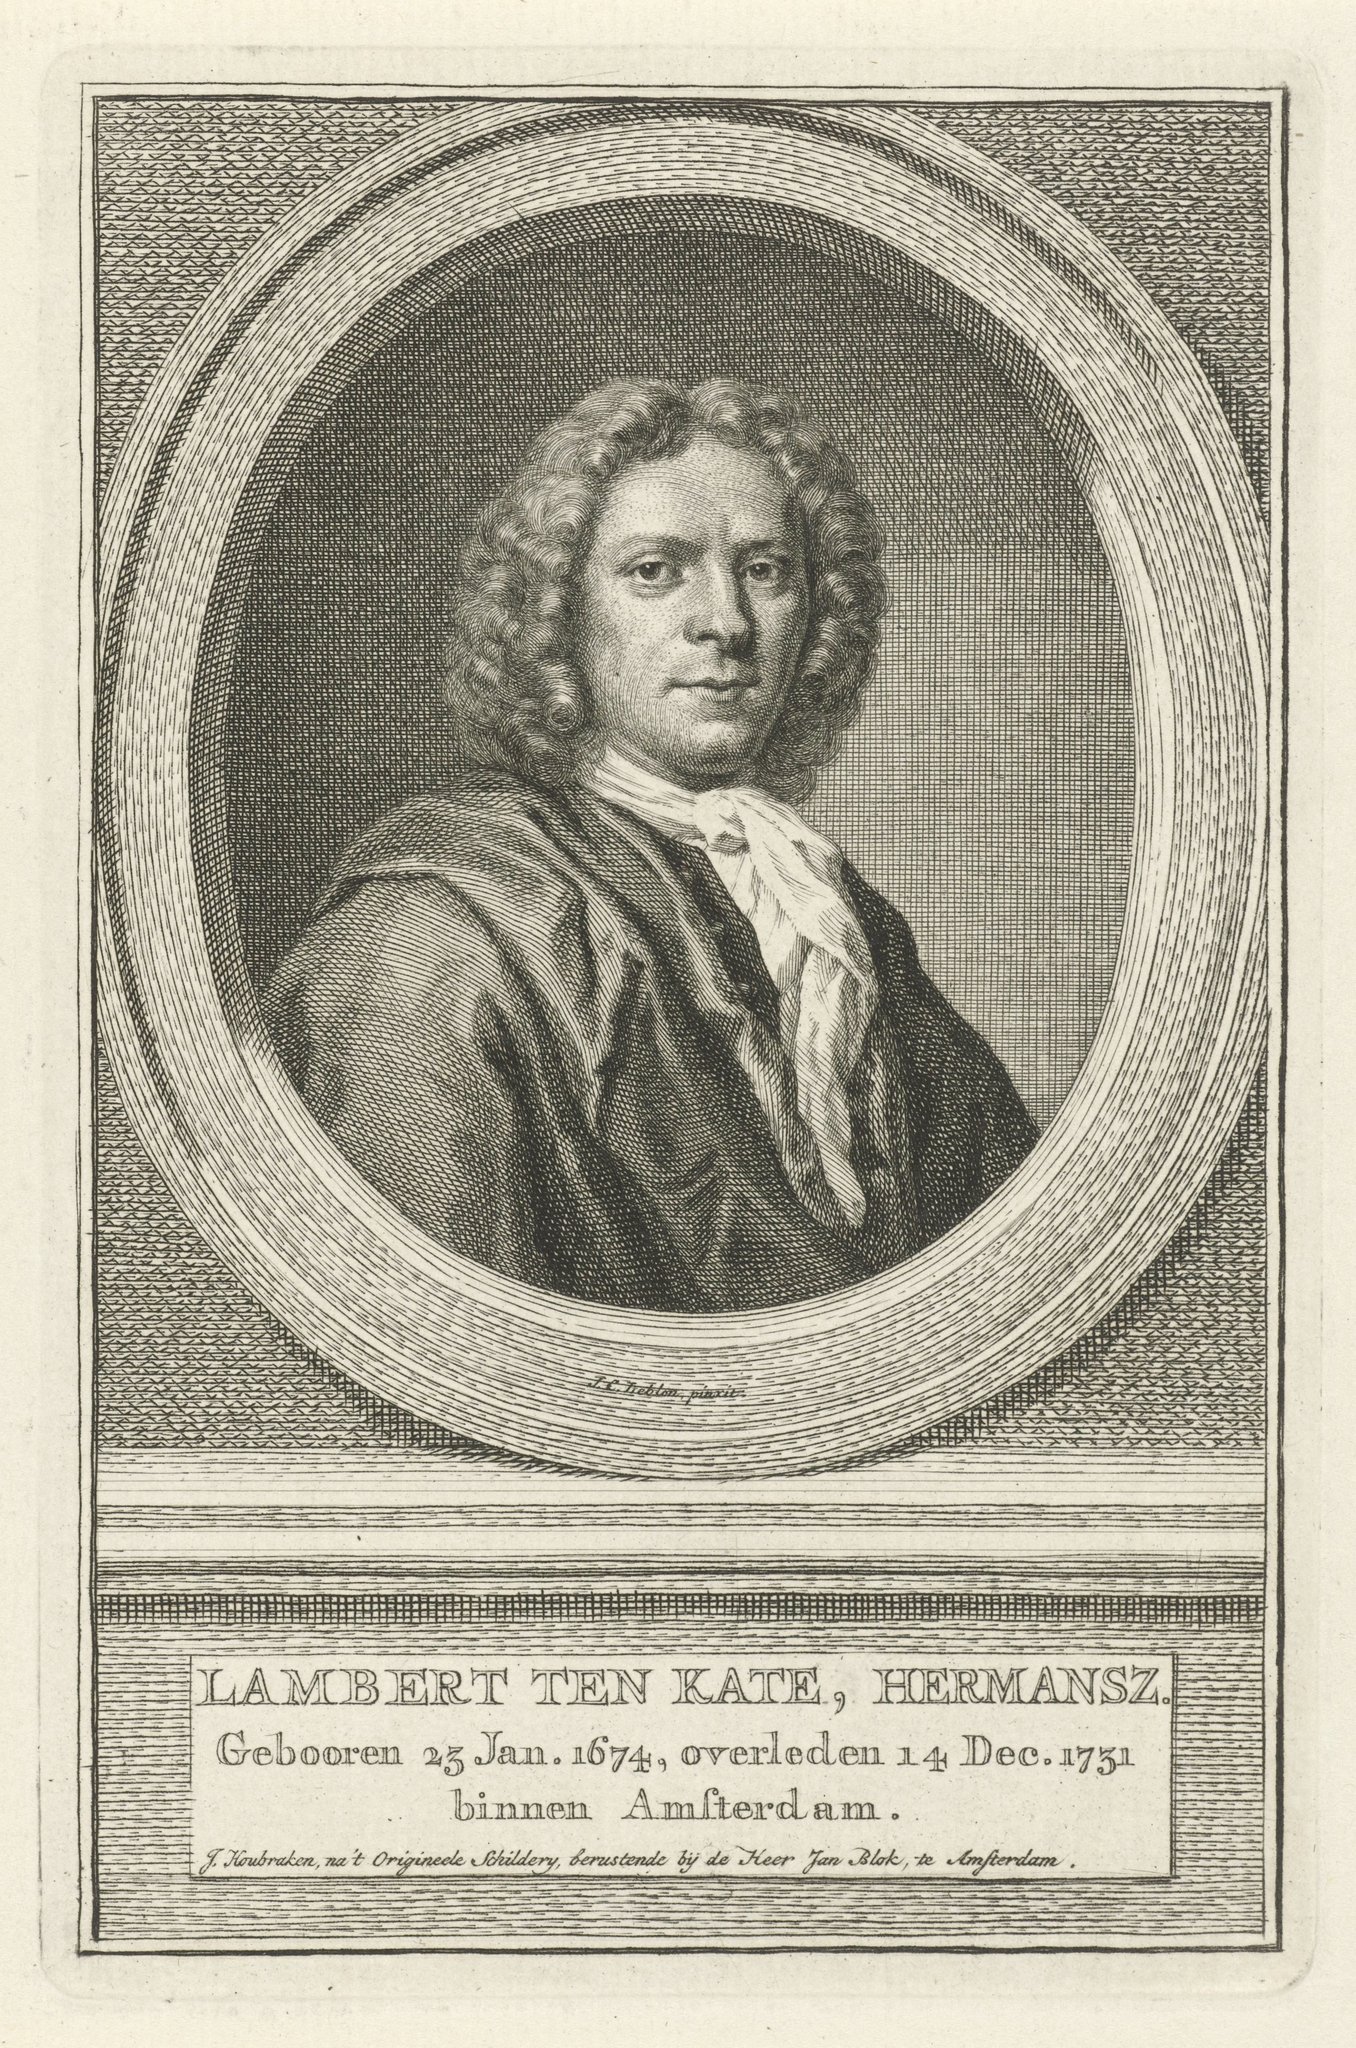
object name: print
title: Portret van Lambert ten Kate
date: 1708-1780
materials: paper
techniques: engraving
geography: amsterdam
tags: amsterdam, print maker, lambert ten kate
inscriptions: collector's mark: Lugt 2228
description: Buste naar rechts van Lambert ten Kate in een ovaal. Het portret rust op een plint waarop zijn naam en gegevens in drie regels in het Nederlands.